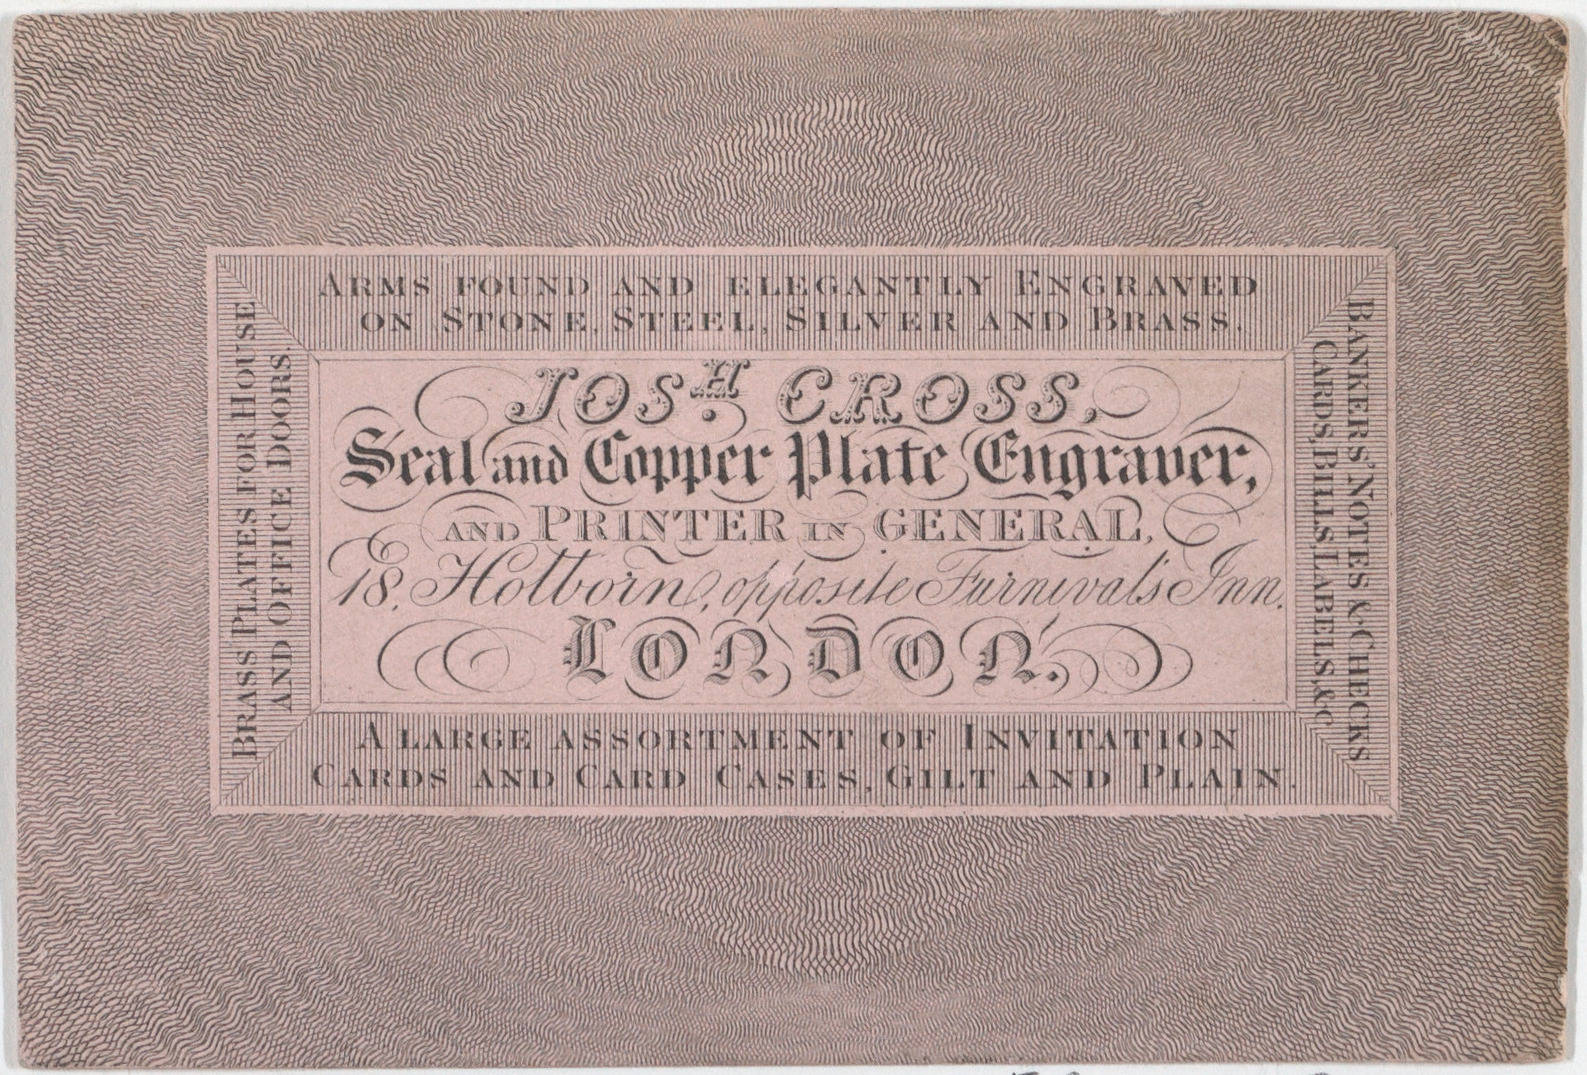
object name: print, trade card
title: Trade Card for Joshua Cross, Seal and Copper Plate Engraver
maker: anonymous, british, 19th century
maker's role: artist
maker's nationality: british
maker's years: 1800-1900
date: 1801-1900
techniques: engraving